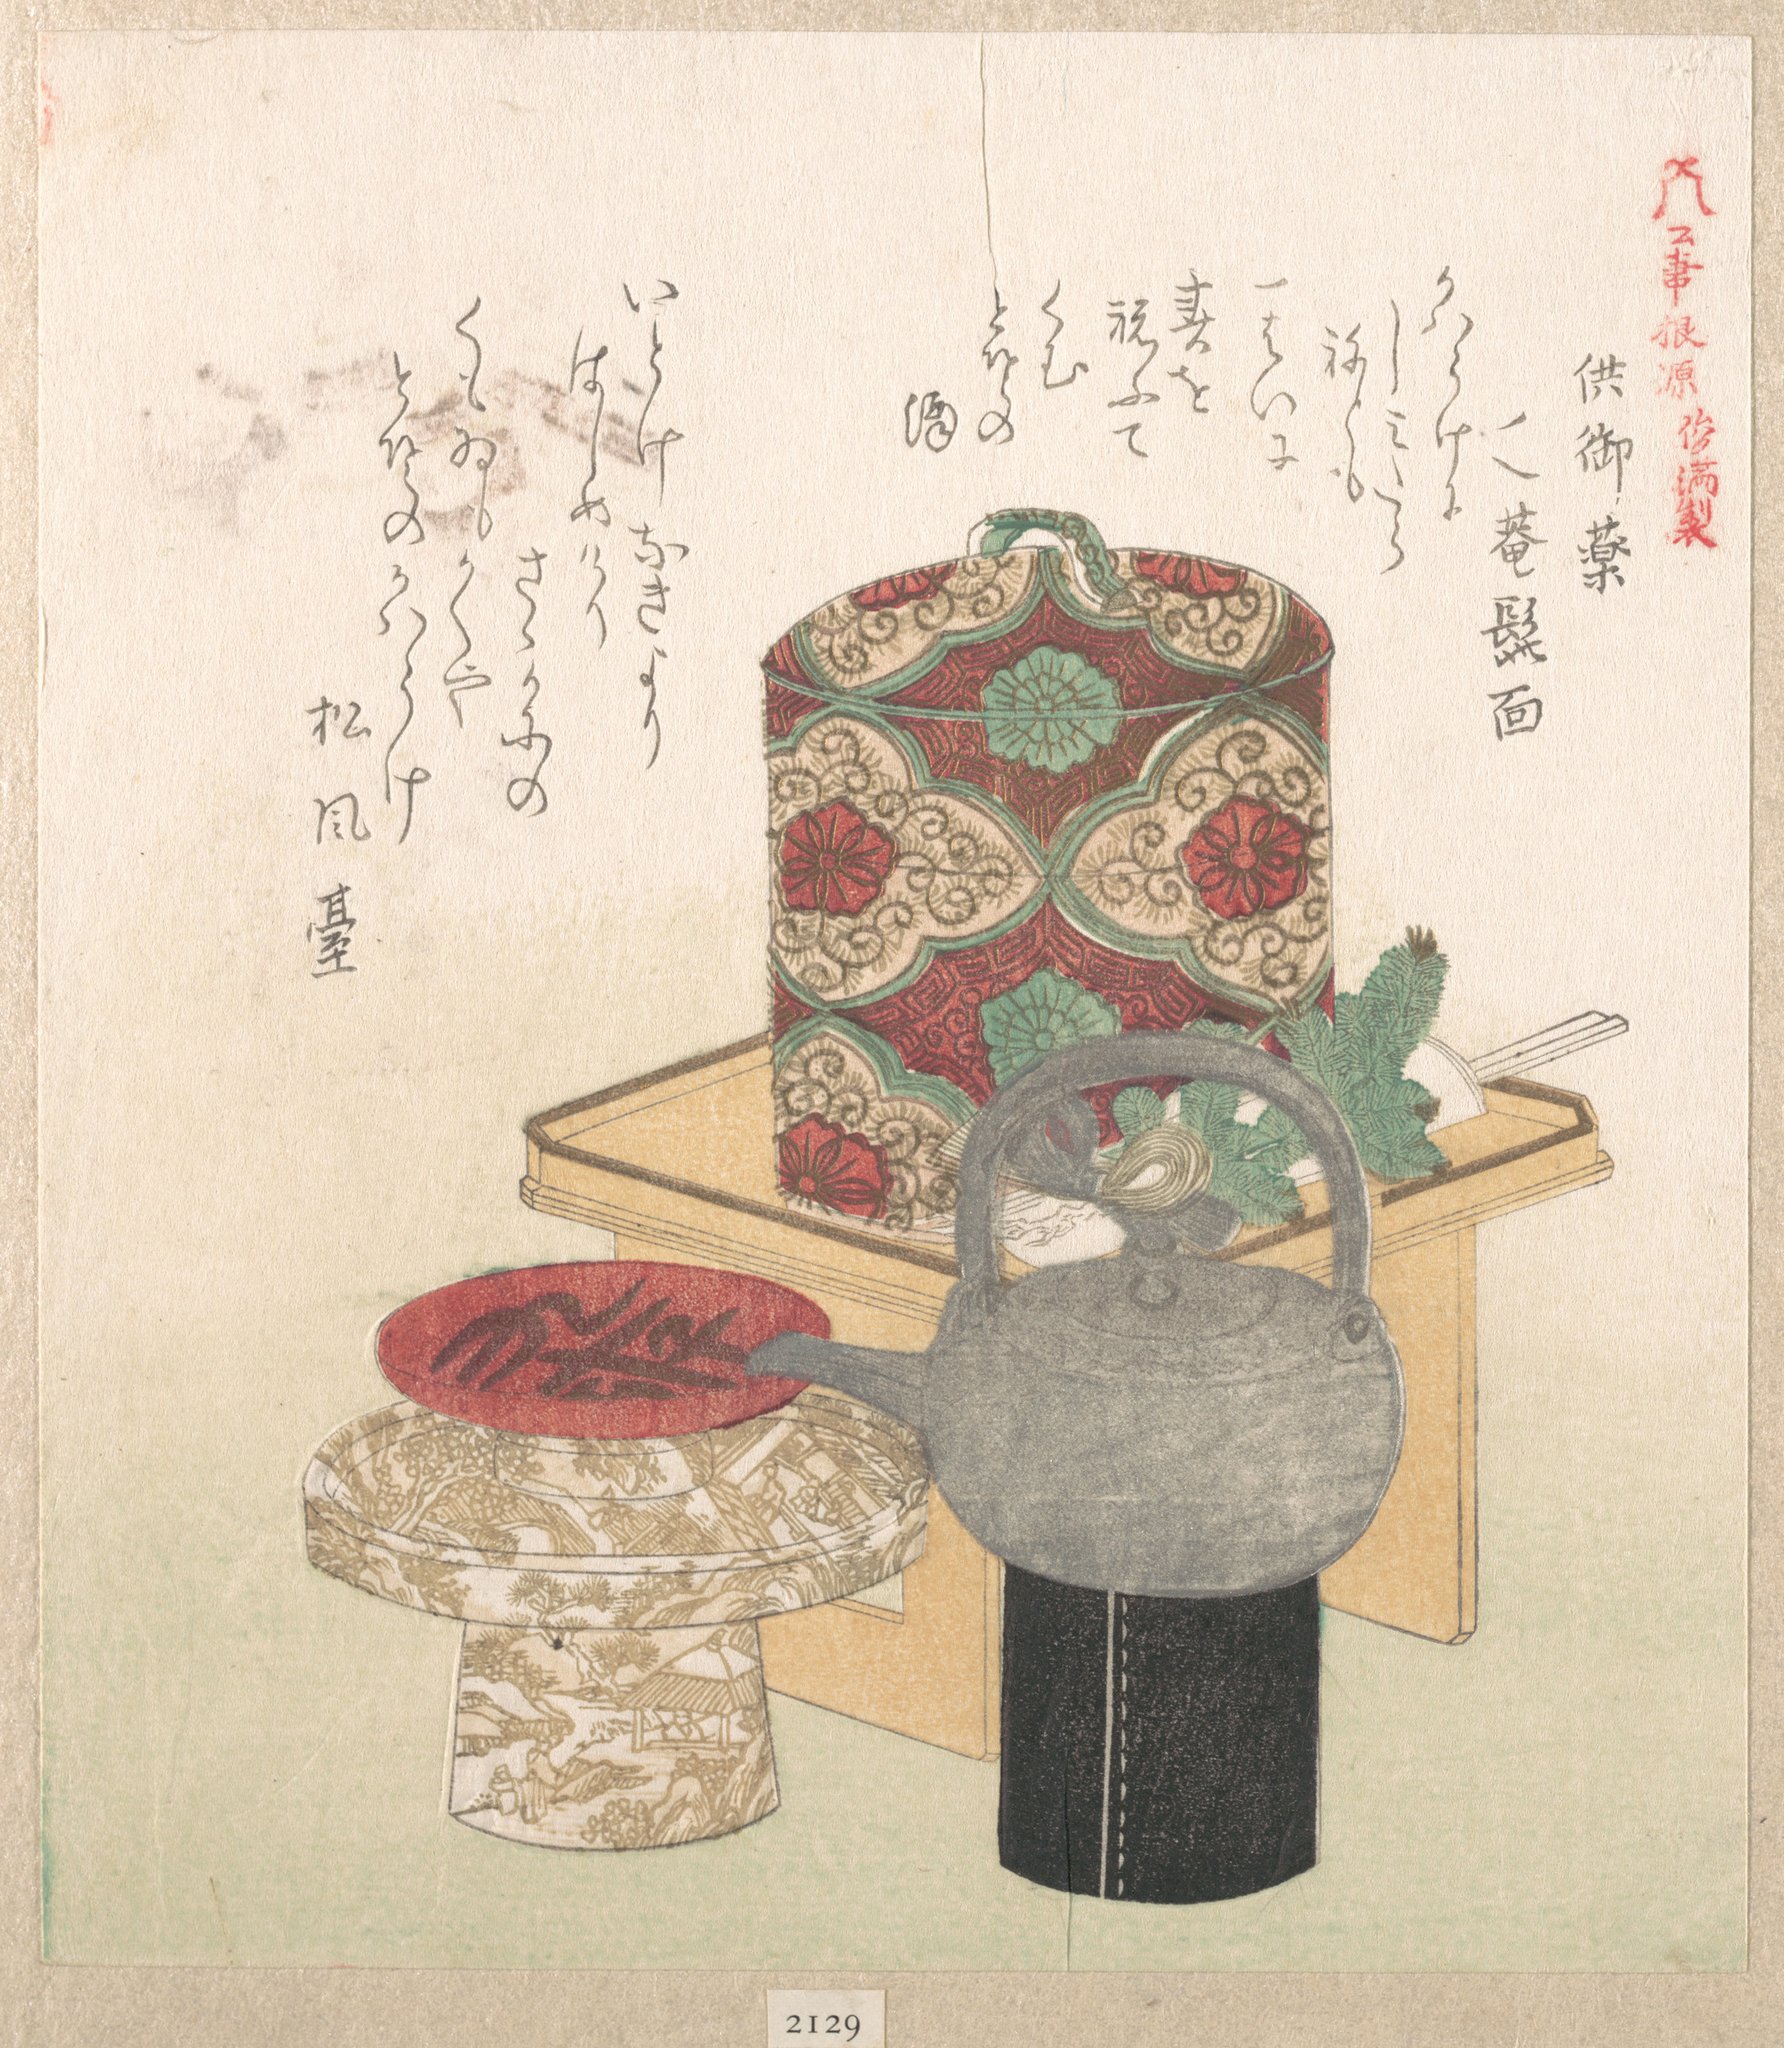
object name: print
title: Wine-Set for the New Year Ceremony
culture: japanese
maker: kubo shunman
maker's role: artist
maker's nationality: japanese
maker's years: 1757-1820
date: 1801-1900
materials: ink, paper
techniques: surimono, woodblock print